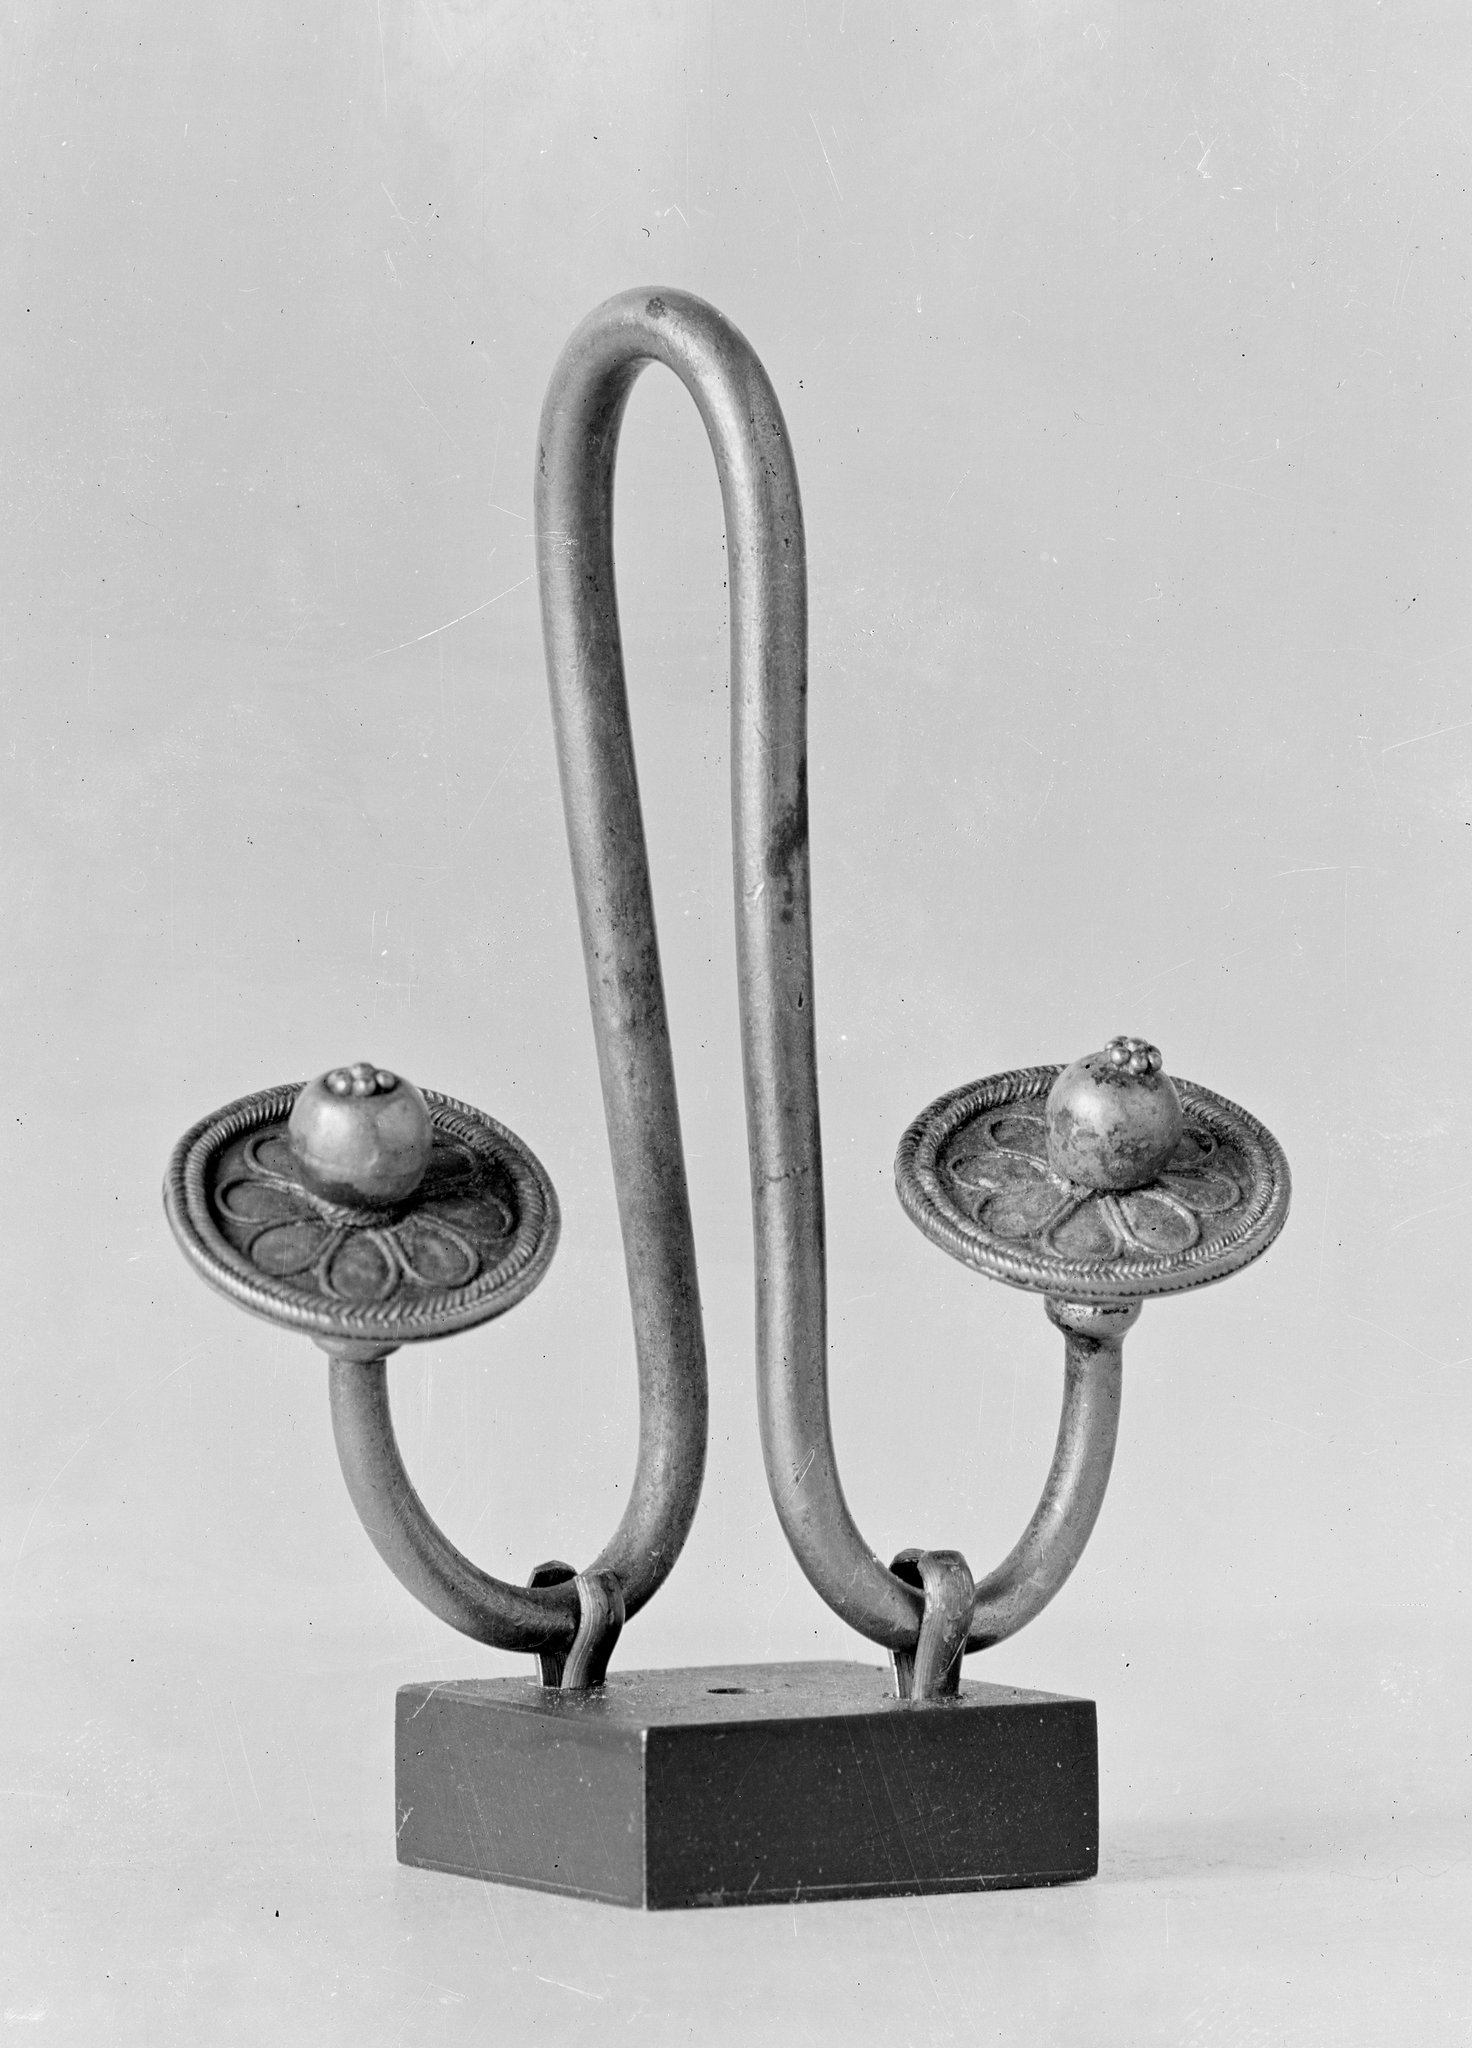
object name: earring pendant, double hook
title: Electrum earring in the form of a double hook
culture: greek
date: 700-501 BCE